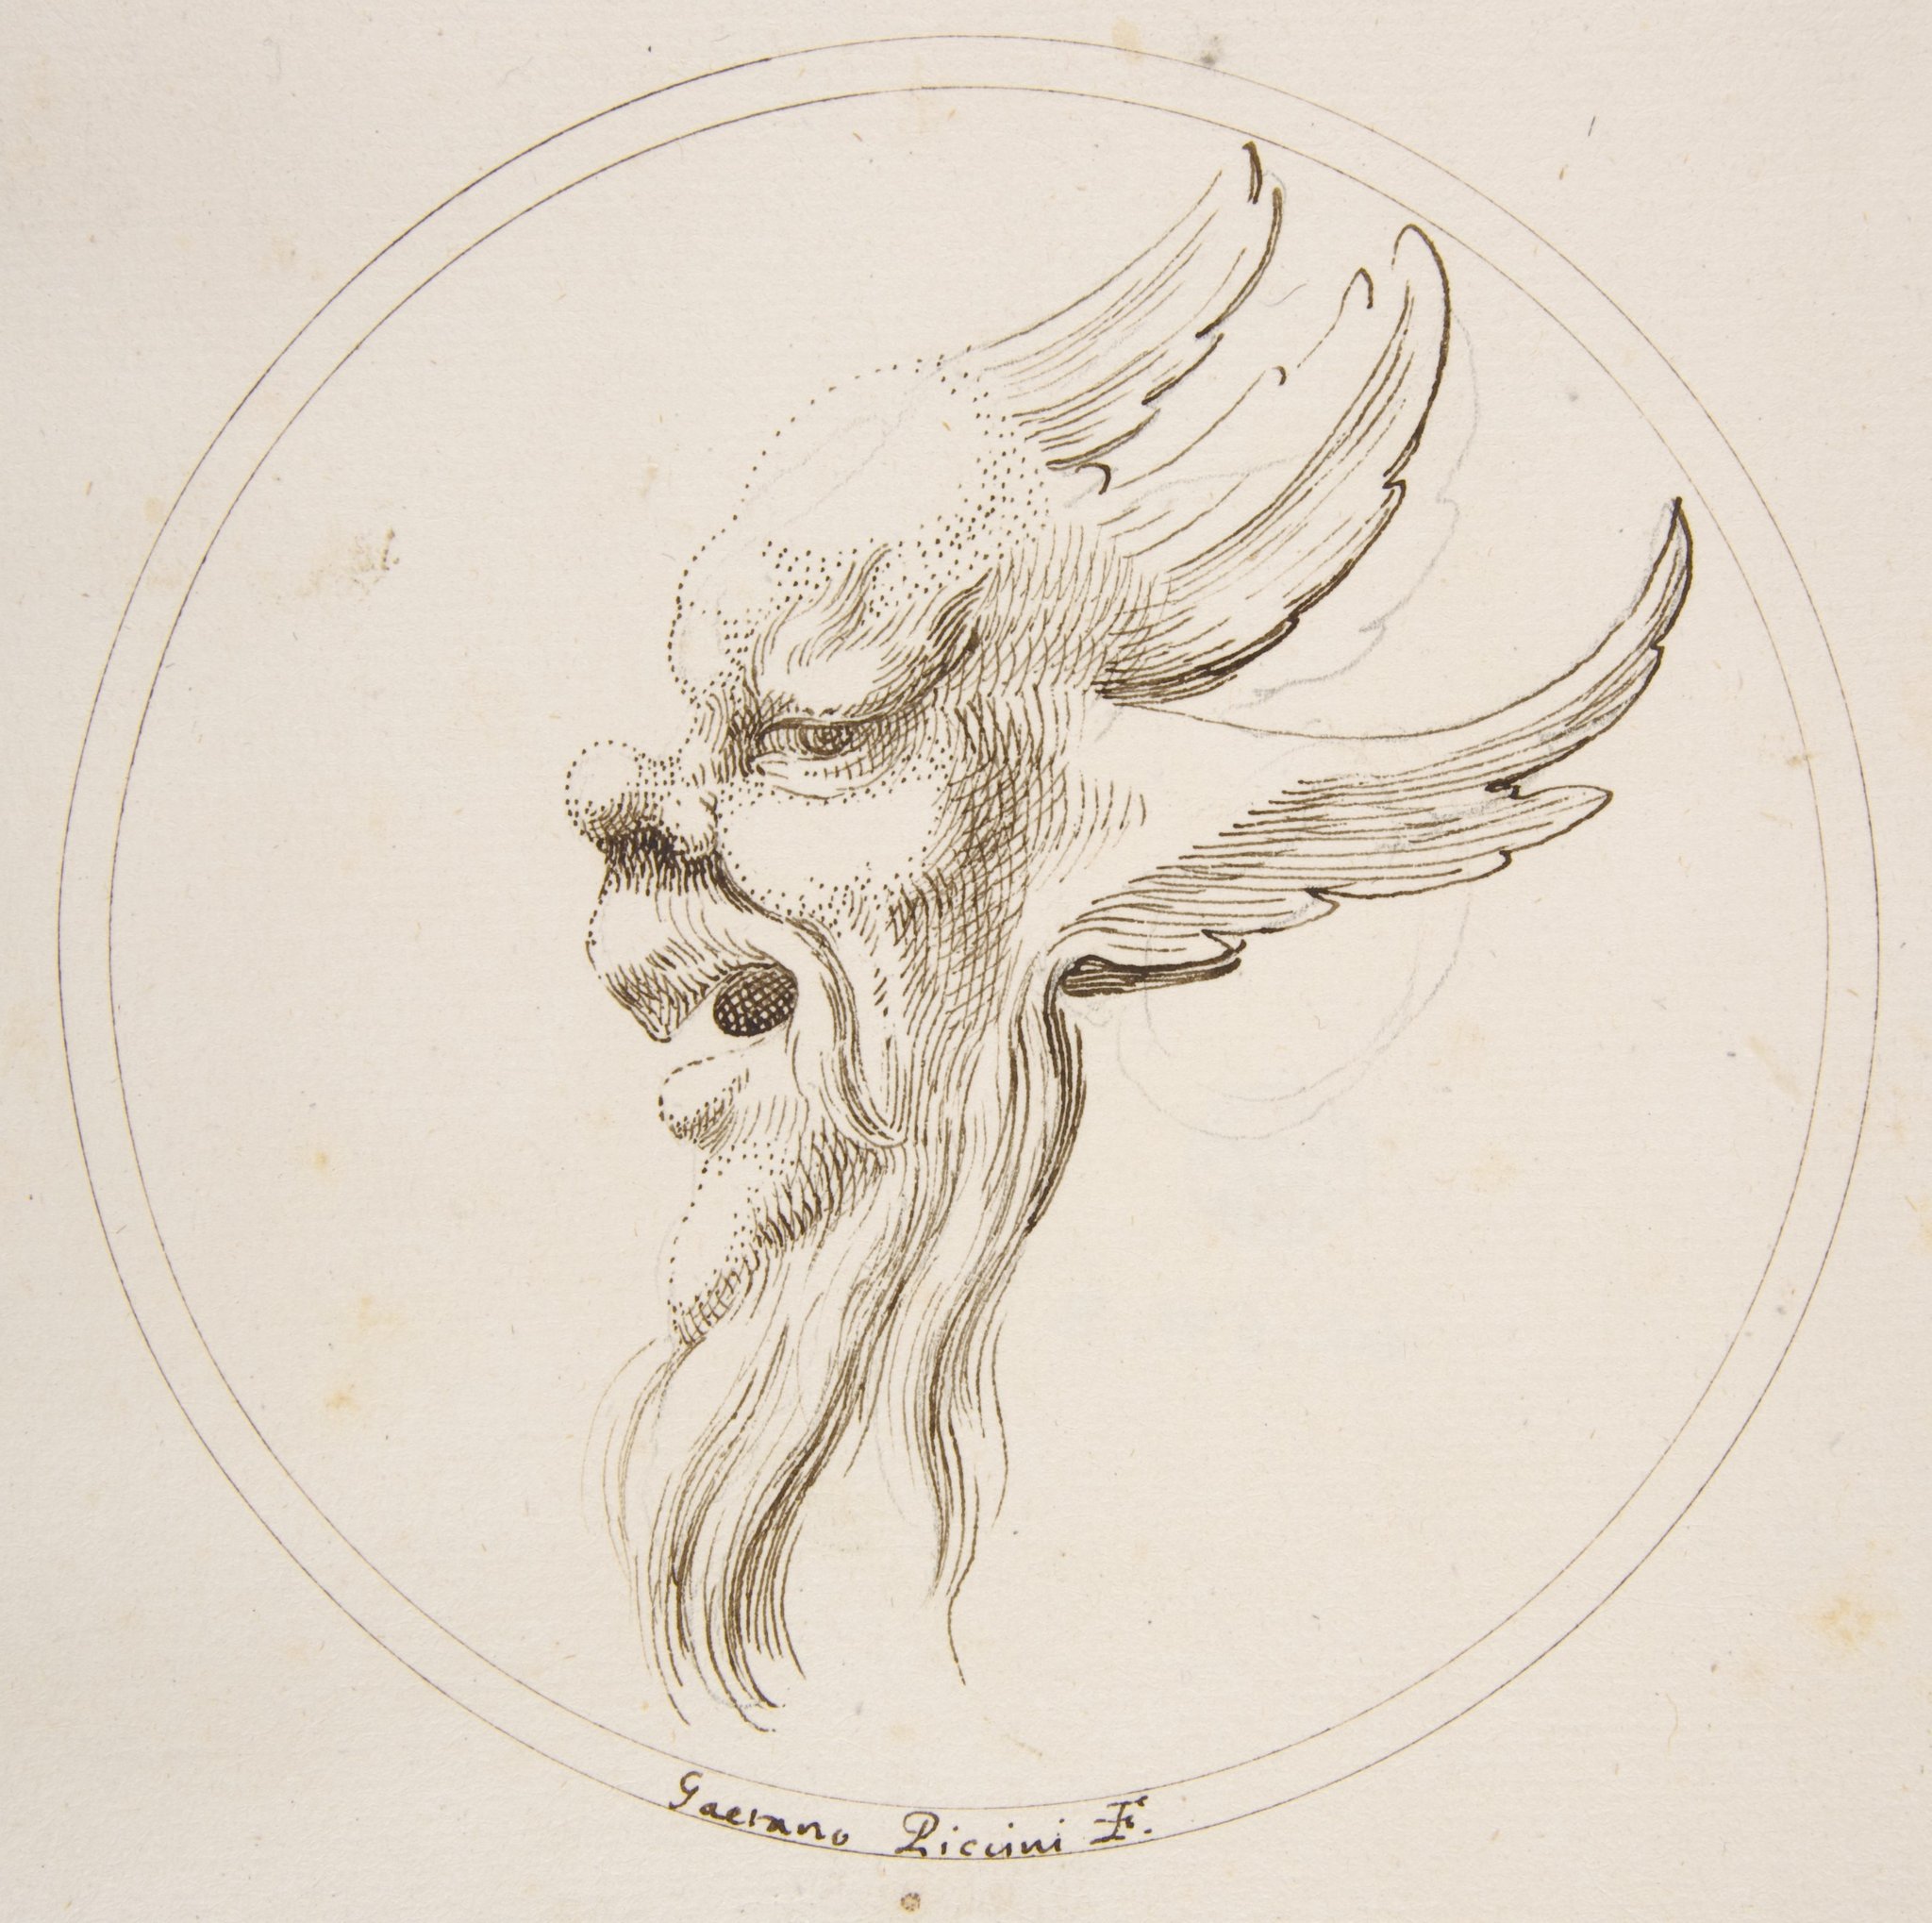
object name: drawing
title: Grotesque Winged and Bearded Head Looking to the Left within a Circle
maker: gaetano piccini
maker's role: artist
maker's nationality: italian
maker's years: 1710-1730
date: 1727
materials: ink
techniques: pen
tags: heads